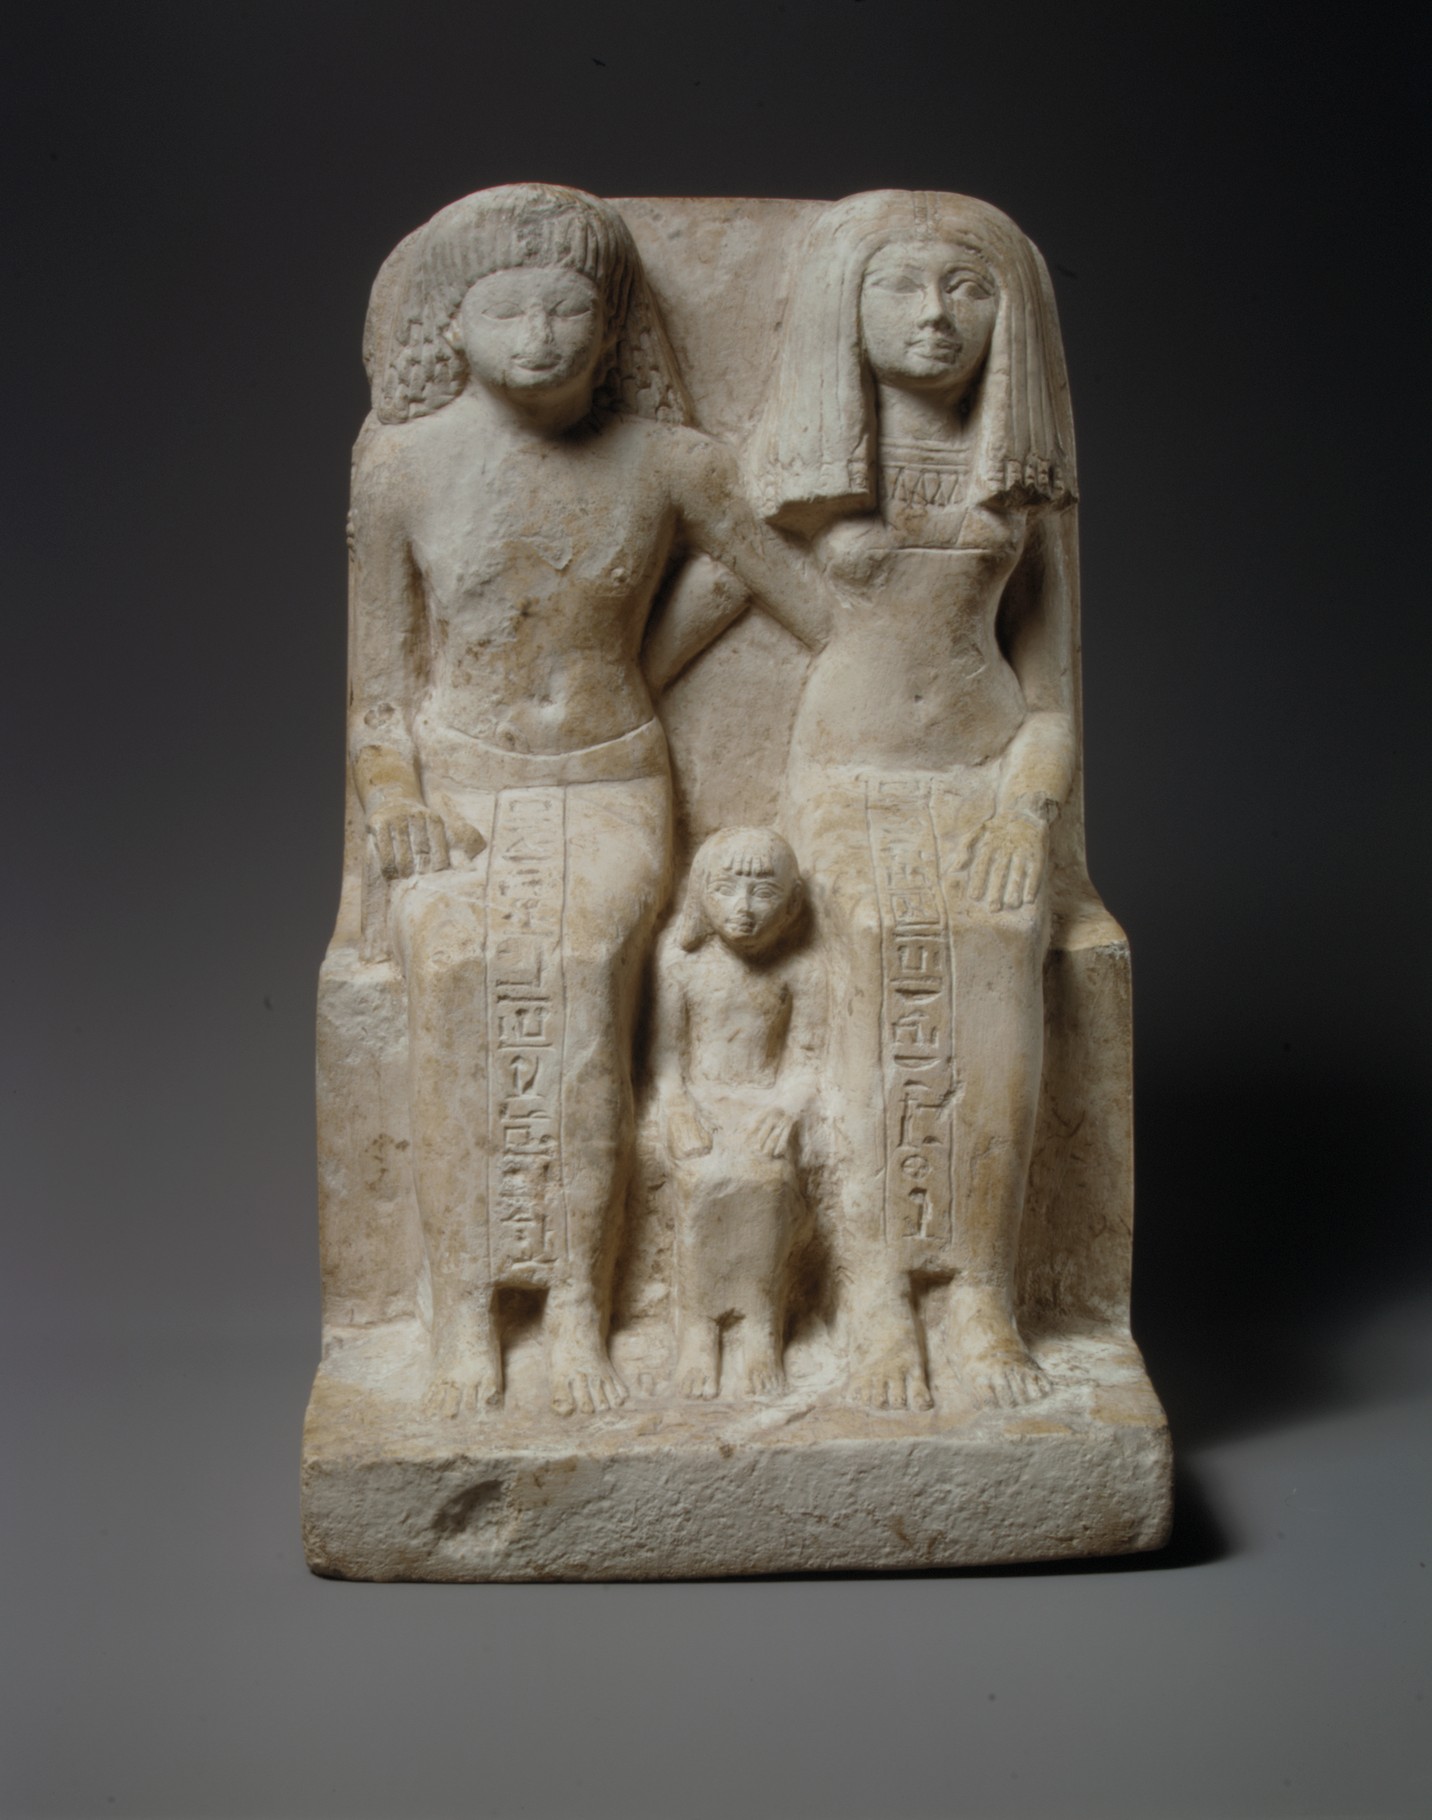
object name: statue, kedamun, nebetinet, family group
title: Statue of Kedamun and His Family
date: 1550-1295 BCE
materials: limestone, paint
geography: upper egypt, thebes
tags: hieroglyphs,family